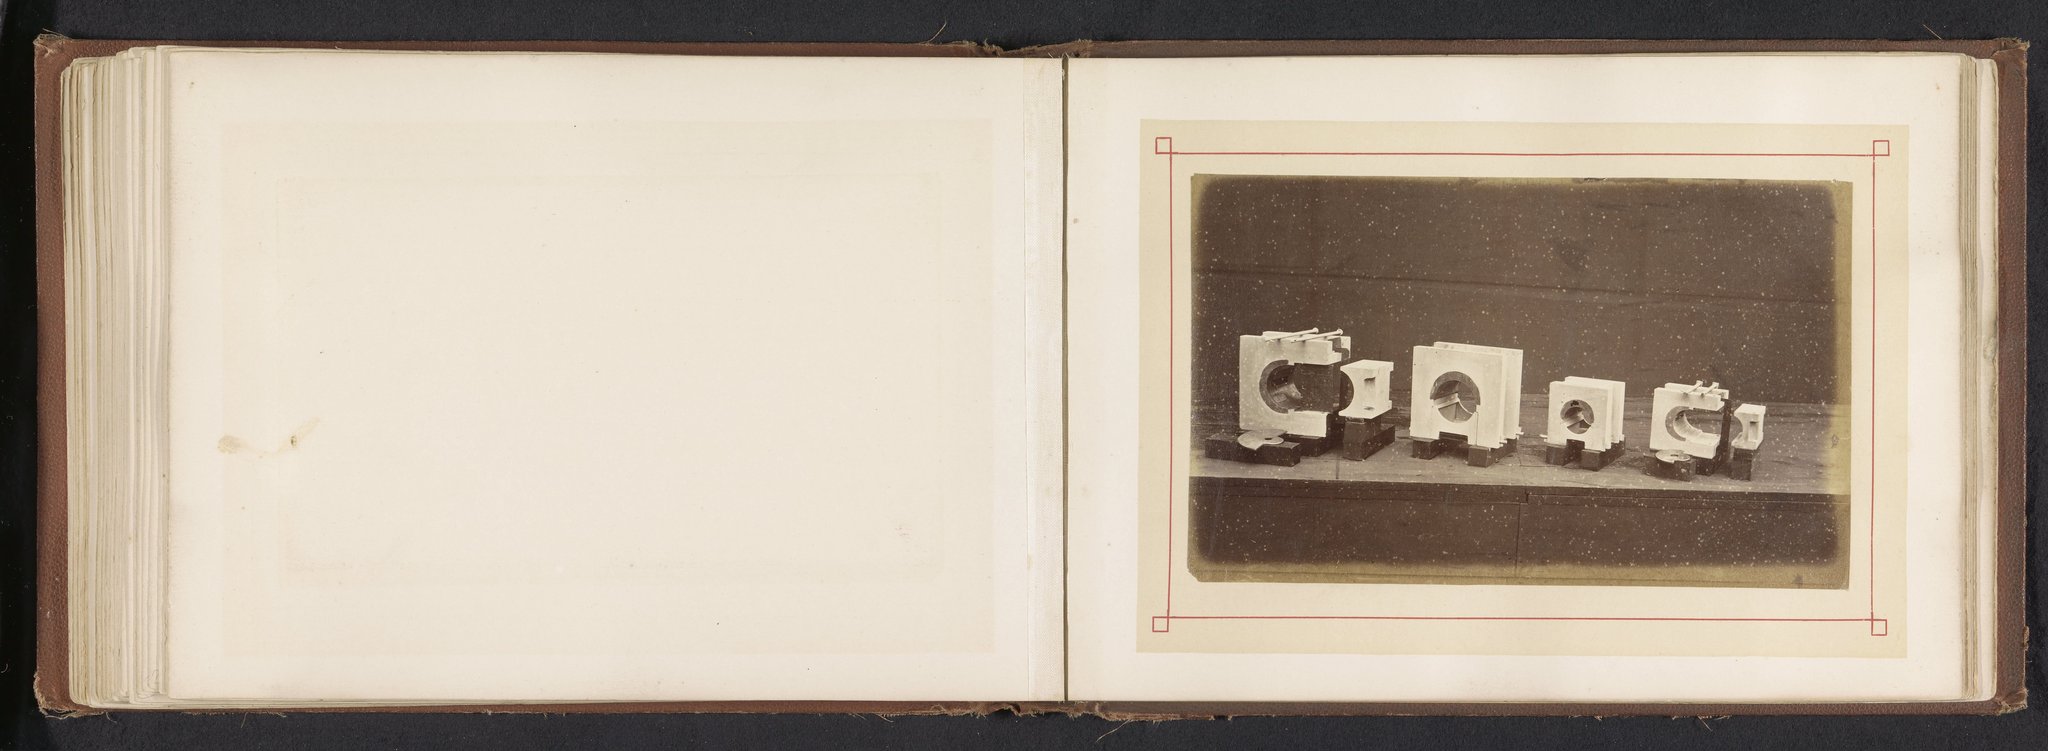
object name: photograph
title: Onderdelen van een stoomlocomotief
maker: george gardner rockwood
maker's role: fotograaf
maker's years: 1832-1911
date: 1861-1871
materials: photographic support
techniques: albumen print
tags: steam locomotive